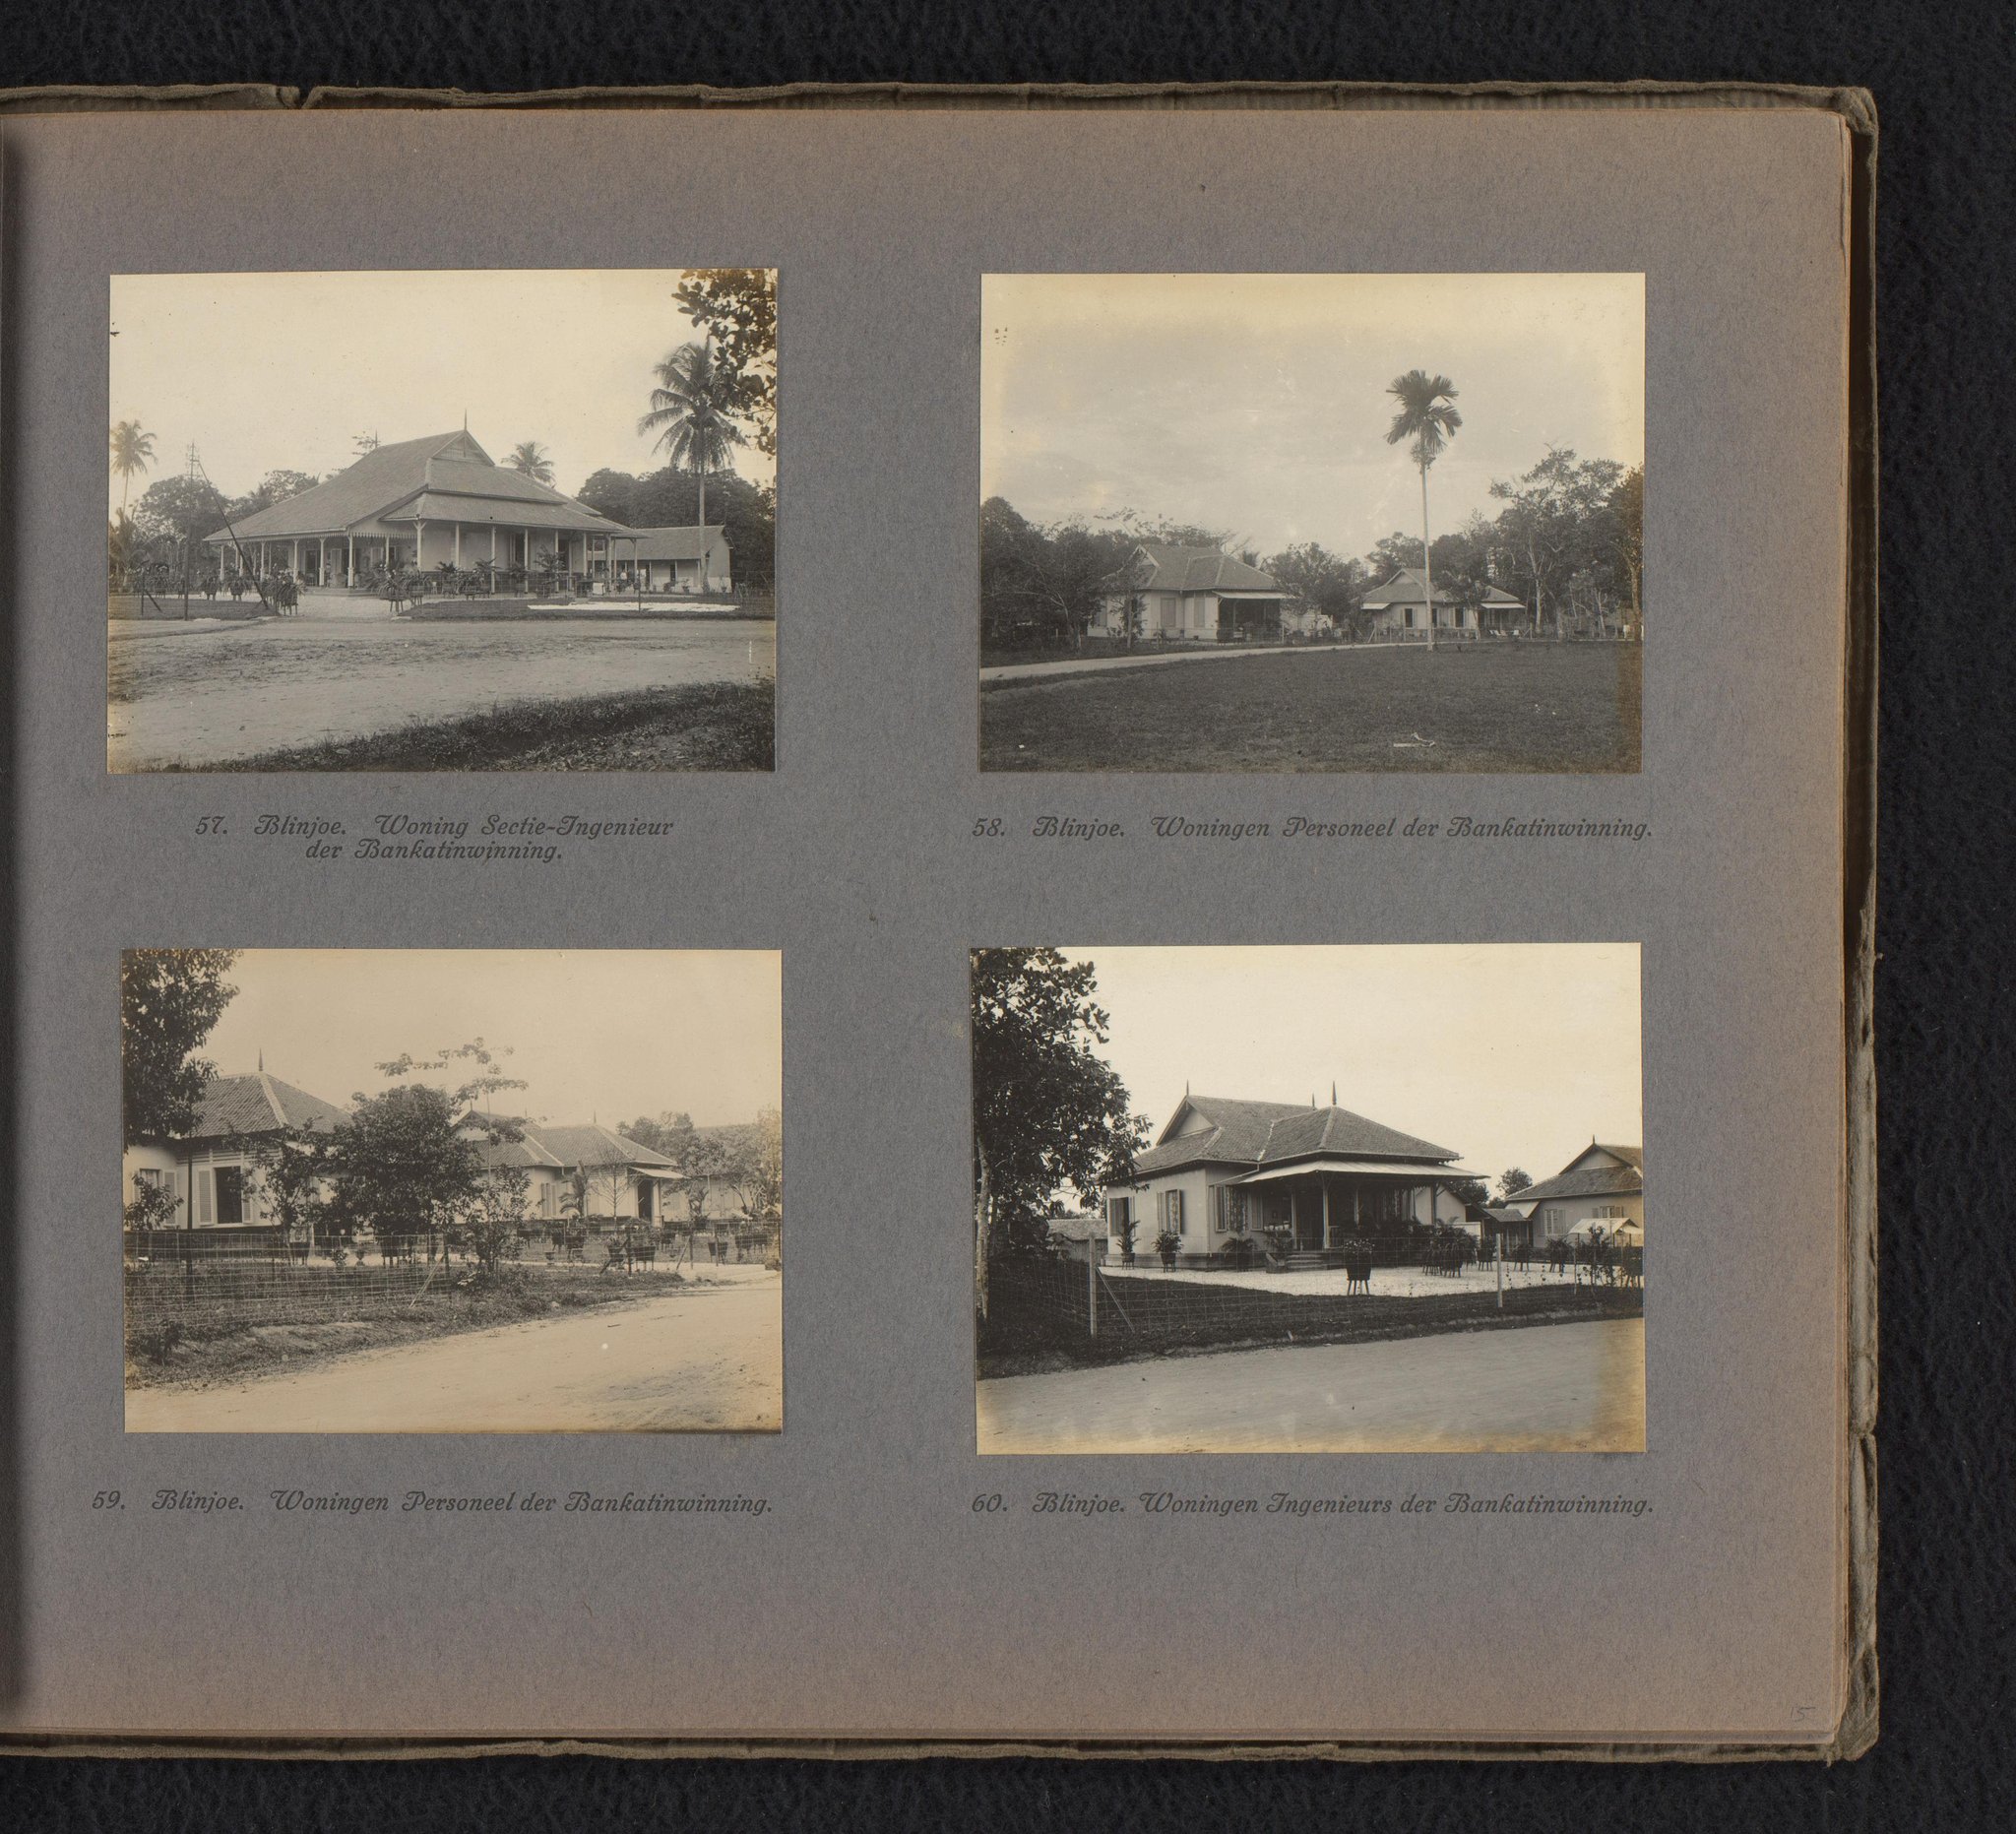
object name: photograph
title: Gebouwen van de Banka-tinwinning te Blinjoe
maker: Anonymous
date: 1907-1919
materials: cardboard, photographic support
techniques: gelatin silver print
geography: bangka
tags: robert julius boers, colonial system, rural housing, e.g. country-house, villa, cottage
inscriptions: inscription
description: Albumblad met vier foto's genummerd 57-60 van verschillende gebouwen te Belinyu (Blinjoe) op Banka: woningen voor personeel van de Banka-tinwinning. Onderdeel van het Banka-Album met foto's over het eiland Banka en de tinwinning door het staatsbedrijf de Banka-tinwinning in de periode ca. 1907-1919.